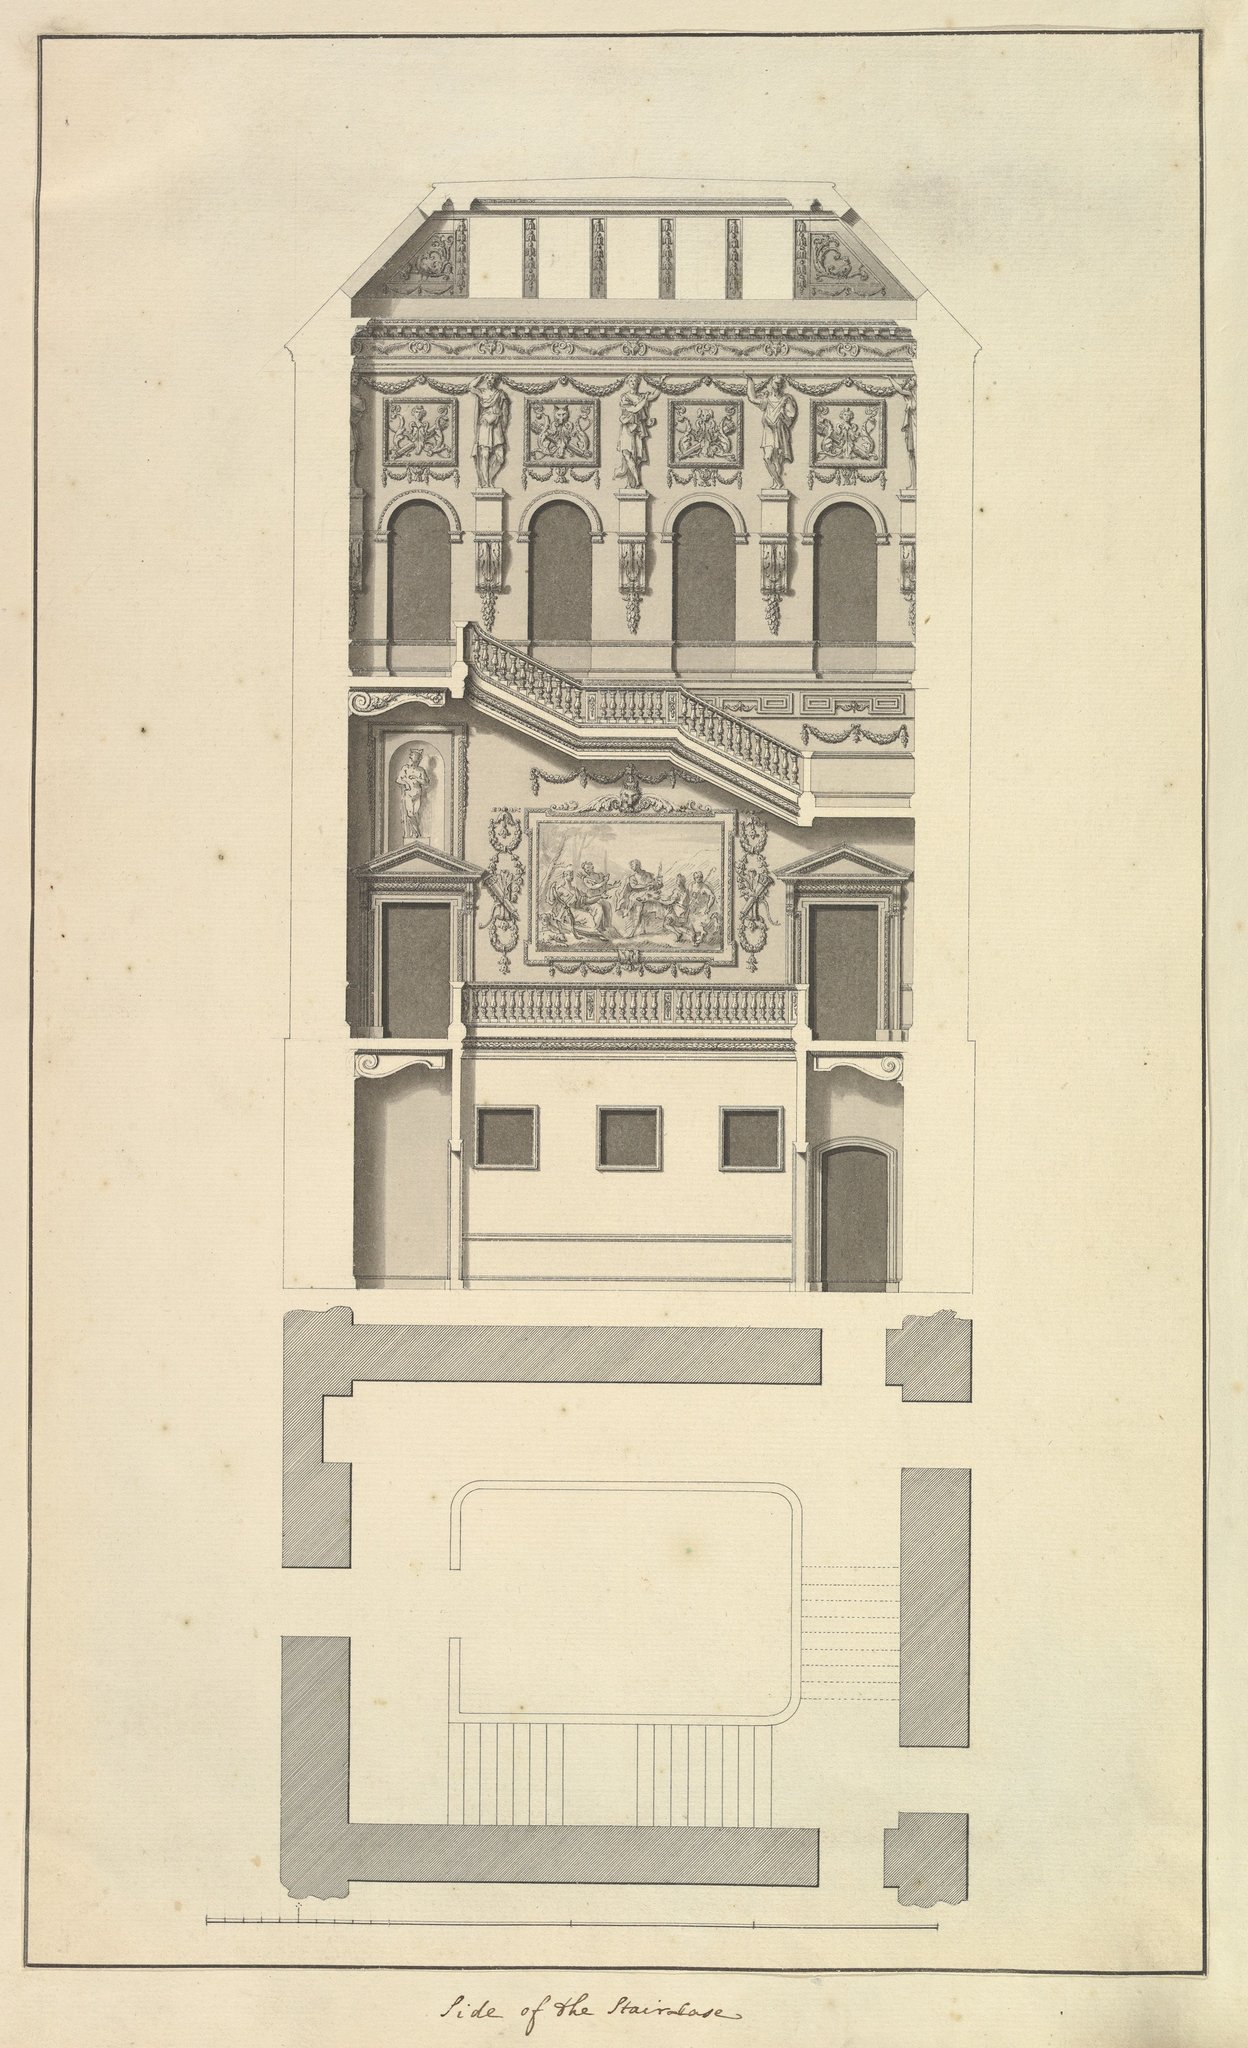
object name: drawing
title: Side of the Staircase, Houghton Hall, Norfolk, Elevation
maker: isaac ware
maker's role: artist and architect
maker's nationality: british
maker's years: 1704-1766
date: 1735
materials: ink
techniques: brush, pen, wash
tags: architecture,houses